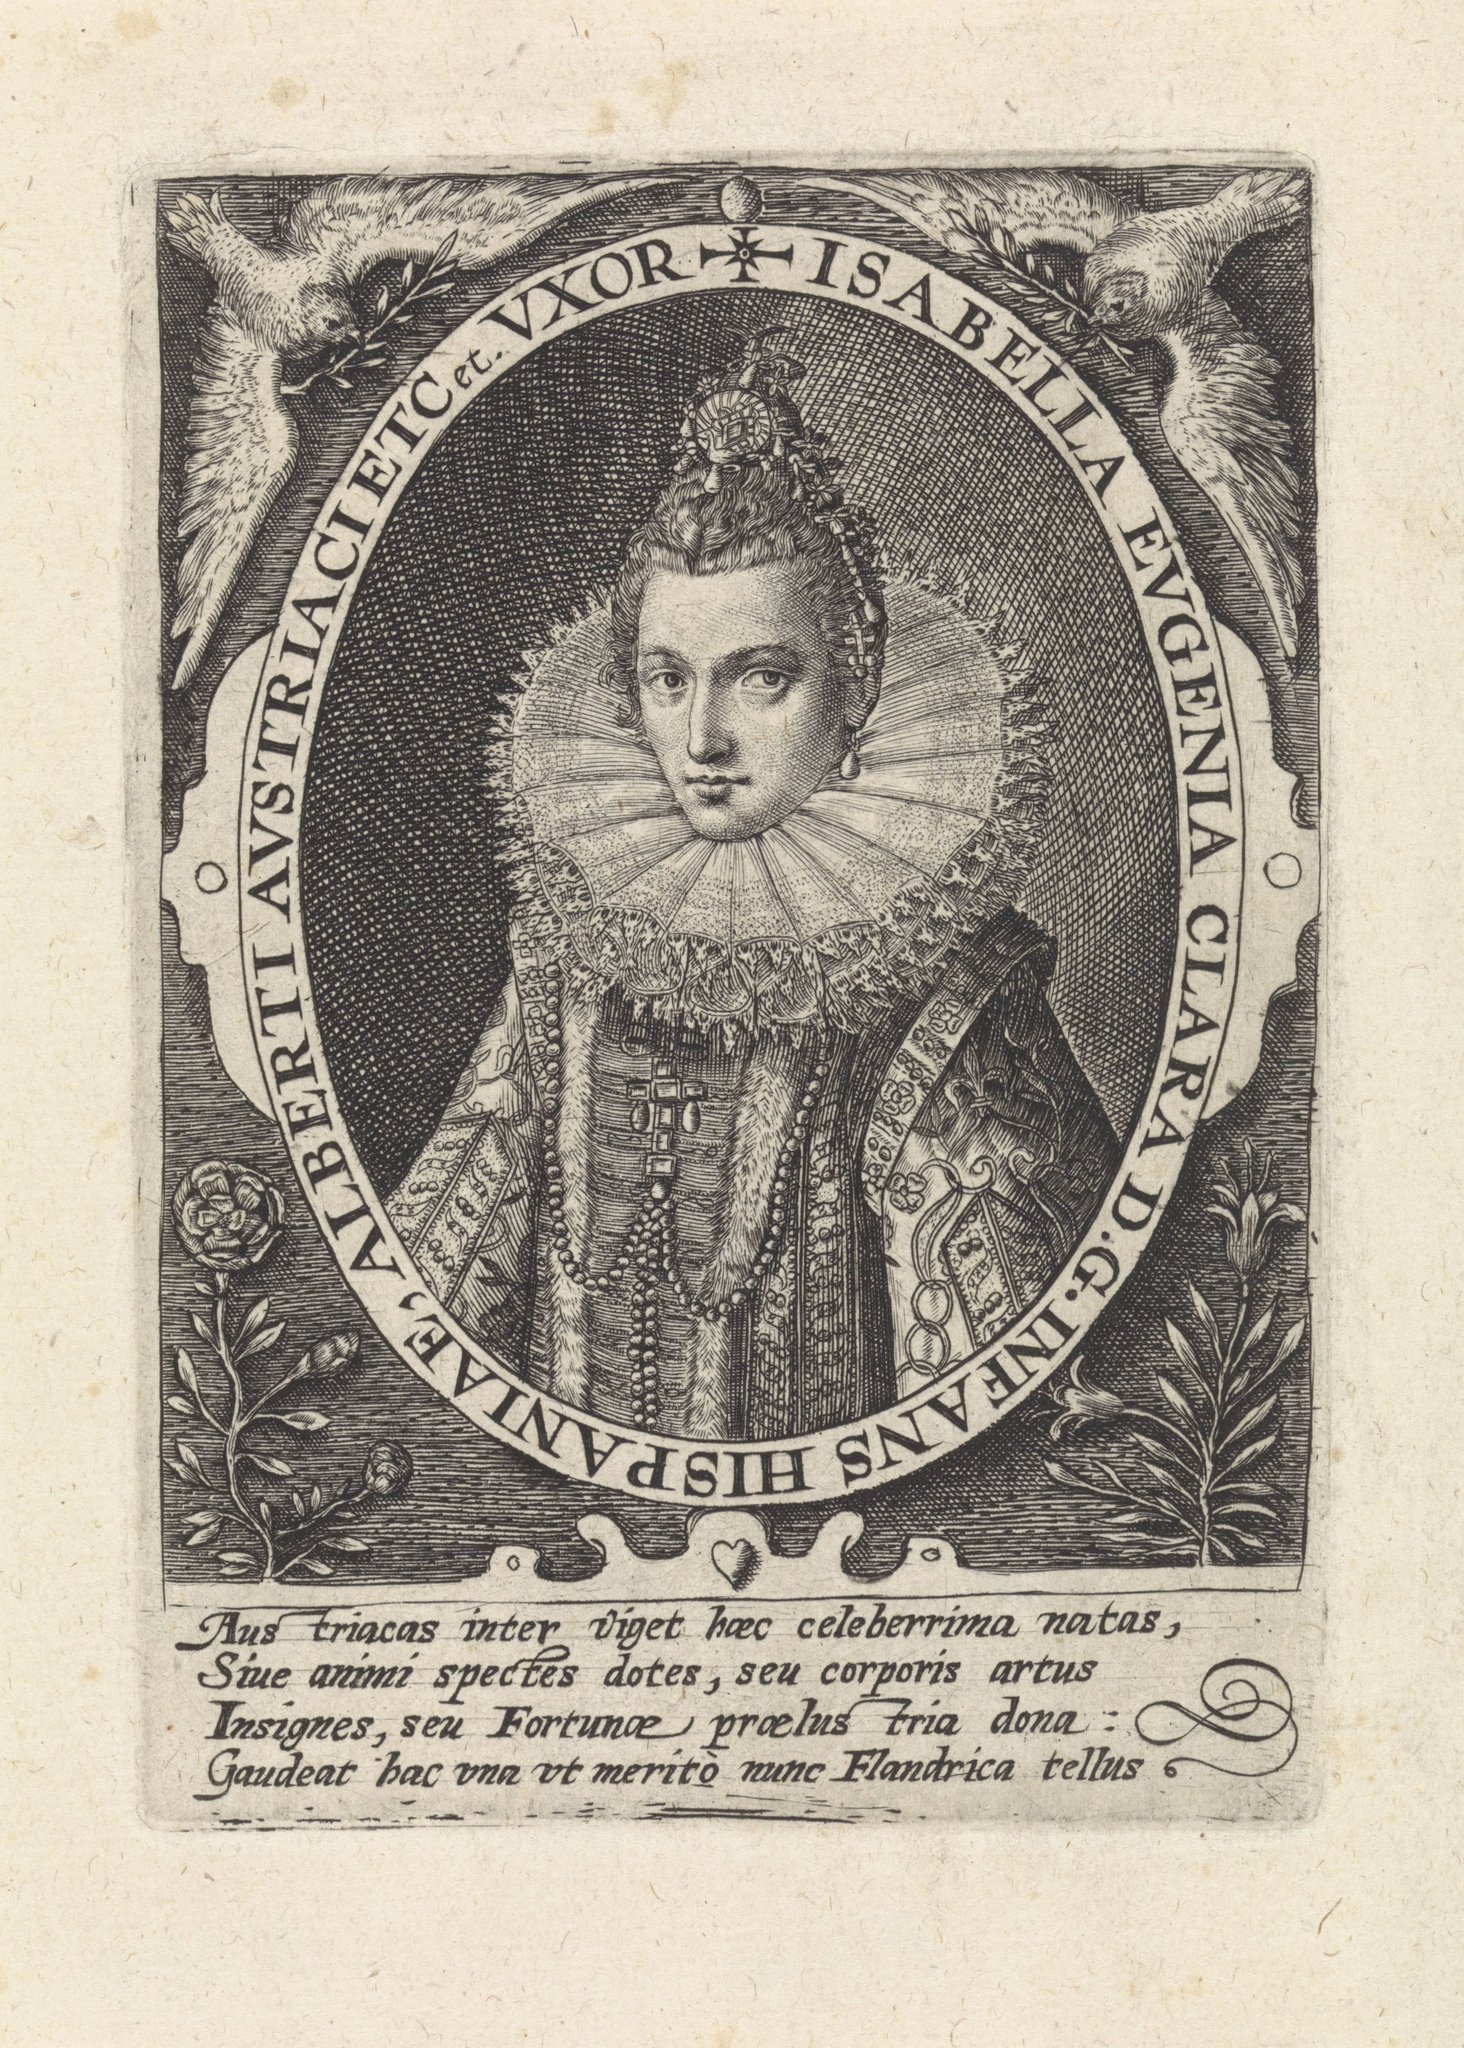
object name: print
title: Portret van Isabella Clara Eugenia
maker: crispijn van de passe (i)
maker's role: draughtsman, print maker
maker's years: 1564-1637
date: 1574-1637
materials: paper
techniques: engraving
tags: infante van spanje isabella clara eugenia, flowers: rose, doves, pigeons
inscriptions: collector's mark: Lugt 2228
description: Portret van Isabella Clara Eugenia, infante van Spanje en gemalin van Albrecht, aartshertog van Oostenrijk. In het randschrift van de omlijsting de naam en functie van de geportretteerde in het Latijn. In de hoeken rozen en twee duiven met twijgjes. In de marge een vierregelig lofdicht in het Latijn.